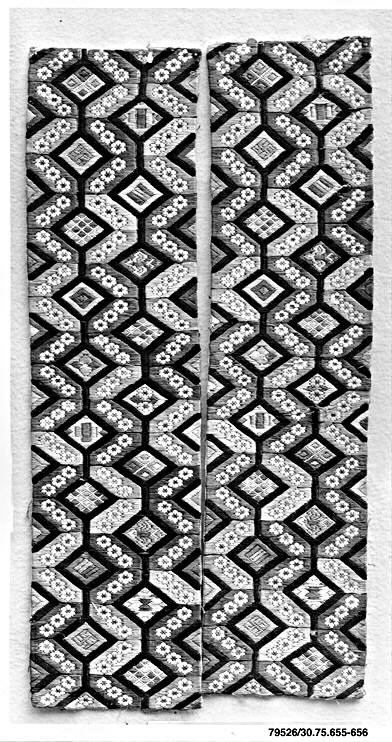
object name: piece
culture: chinese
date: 1644-1911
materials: silk